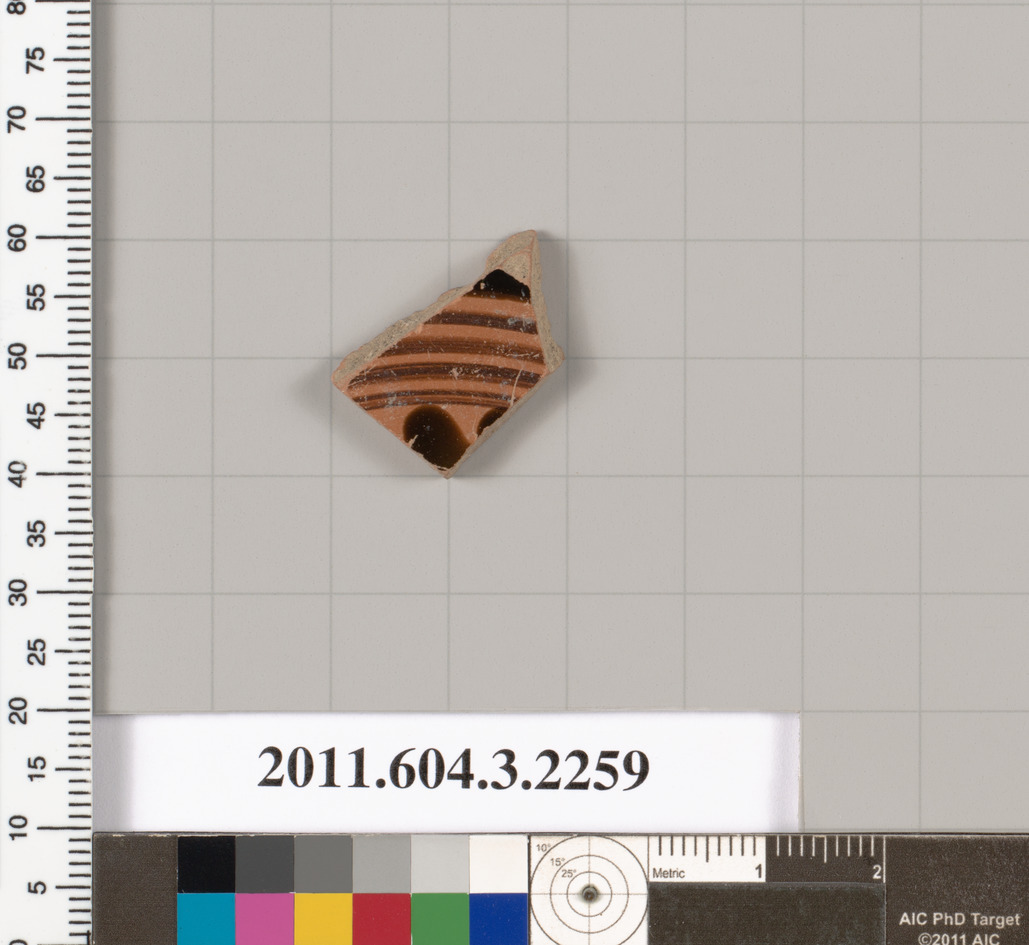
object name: kylix fragment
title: Terracotta fragment of a kylix (drinking cup)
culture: greek, attic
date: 600-401 BCE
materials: terracotta